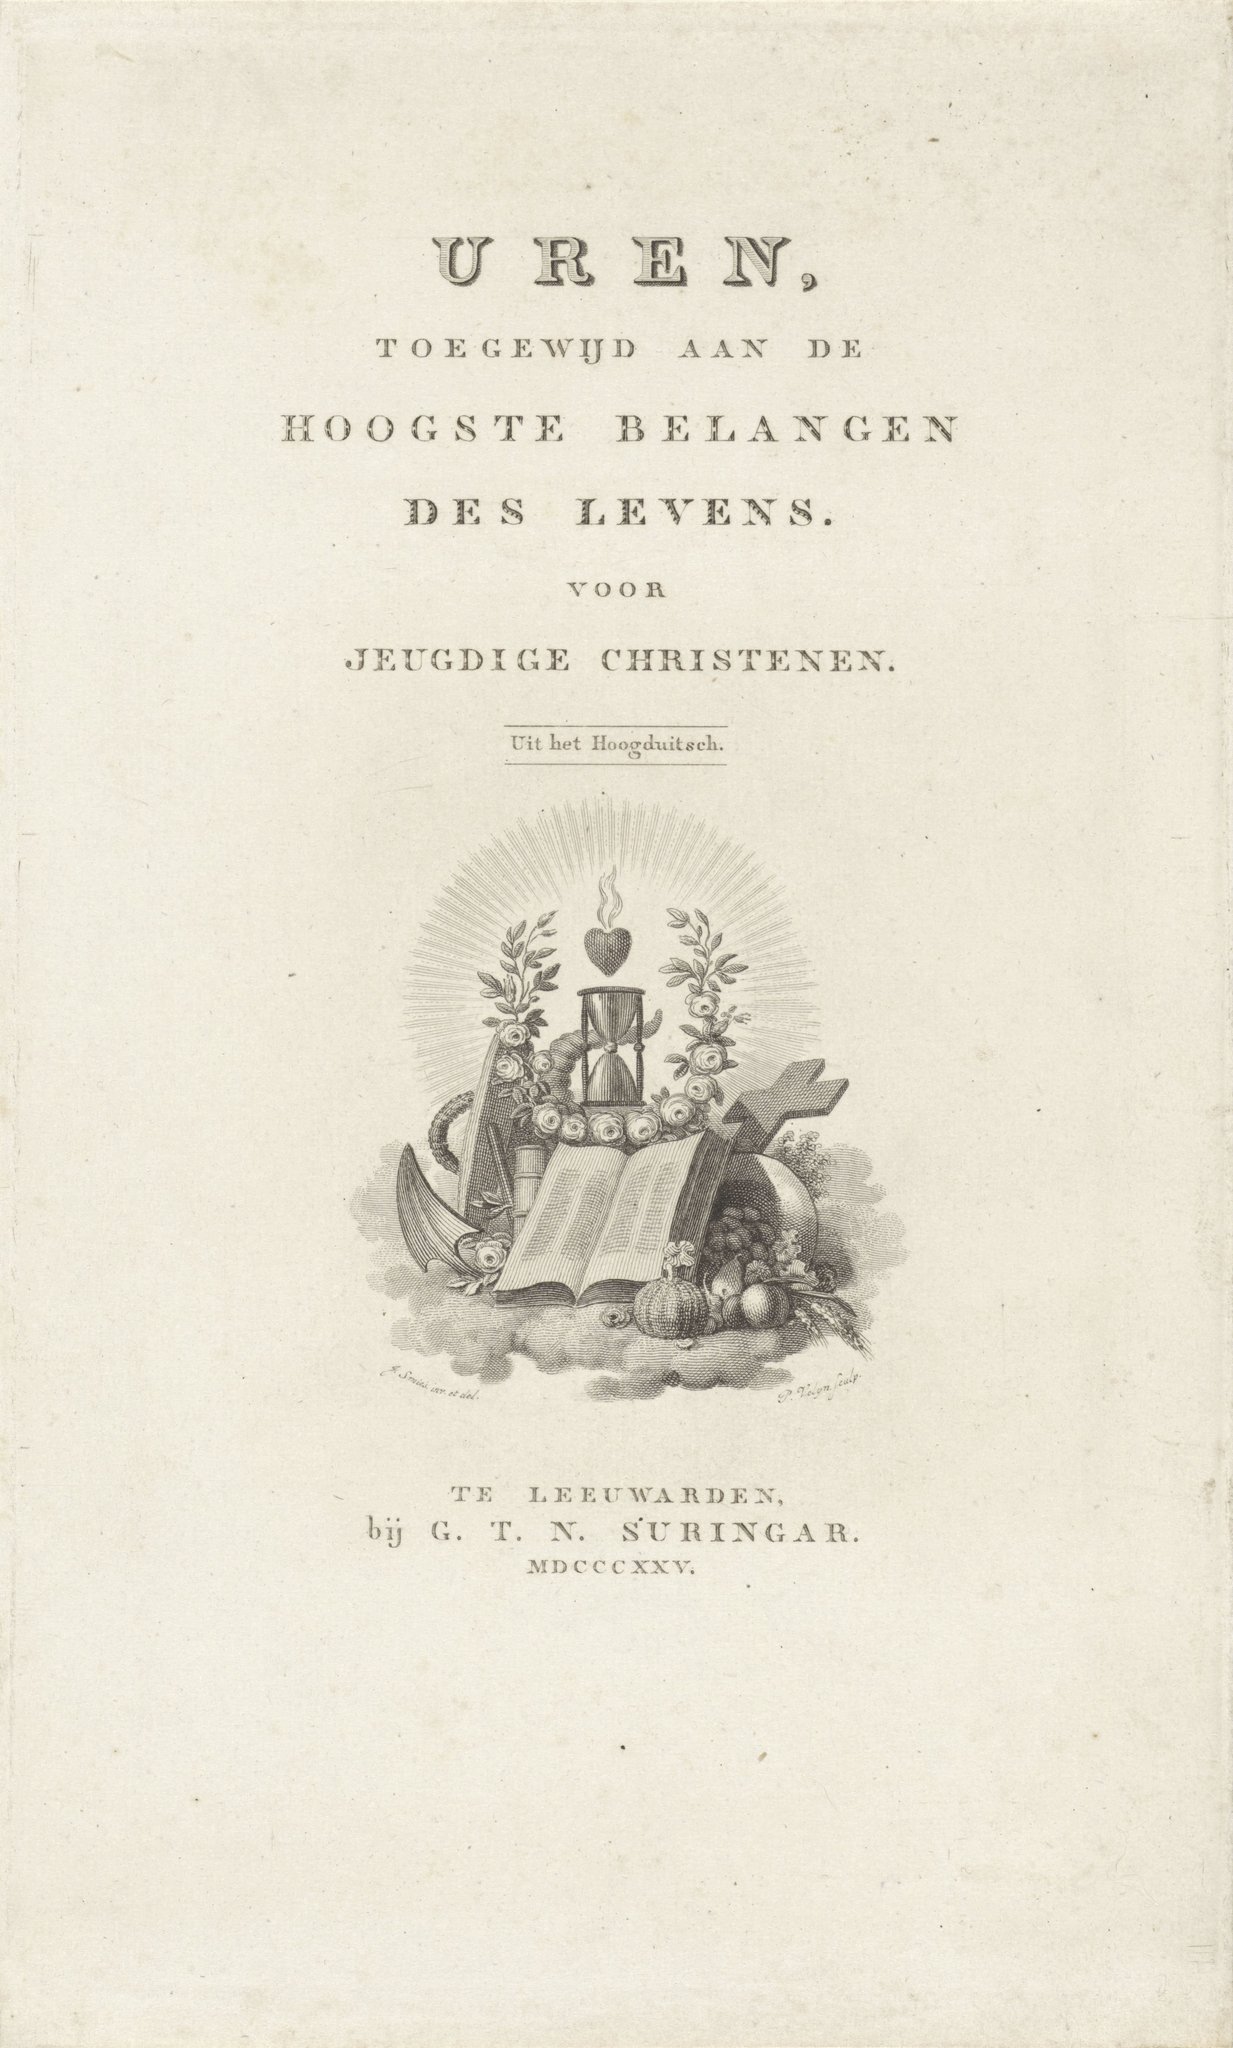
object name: print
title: Titelpagina voor: Uren toegewijd aan de hoogste belangen des levens: voor jeugdige christenen, 1825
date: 1825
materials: paper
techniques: engraving, etching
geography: leeuwarden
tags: 'cornucopia', horn of plenty, the sacred heart, light shining out of the heavens, the bible as a book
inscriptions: collector's mark: Lugt 2228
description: Een opengeslagen bijbel, een zandloper, een bloemenkrans, een crucifix, een hoorn des overvloeds en een anker, waarboven een brandend hart in een stralenkrans.